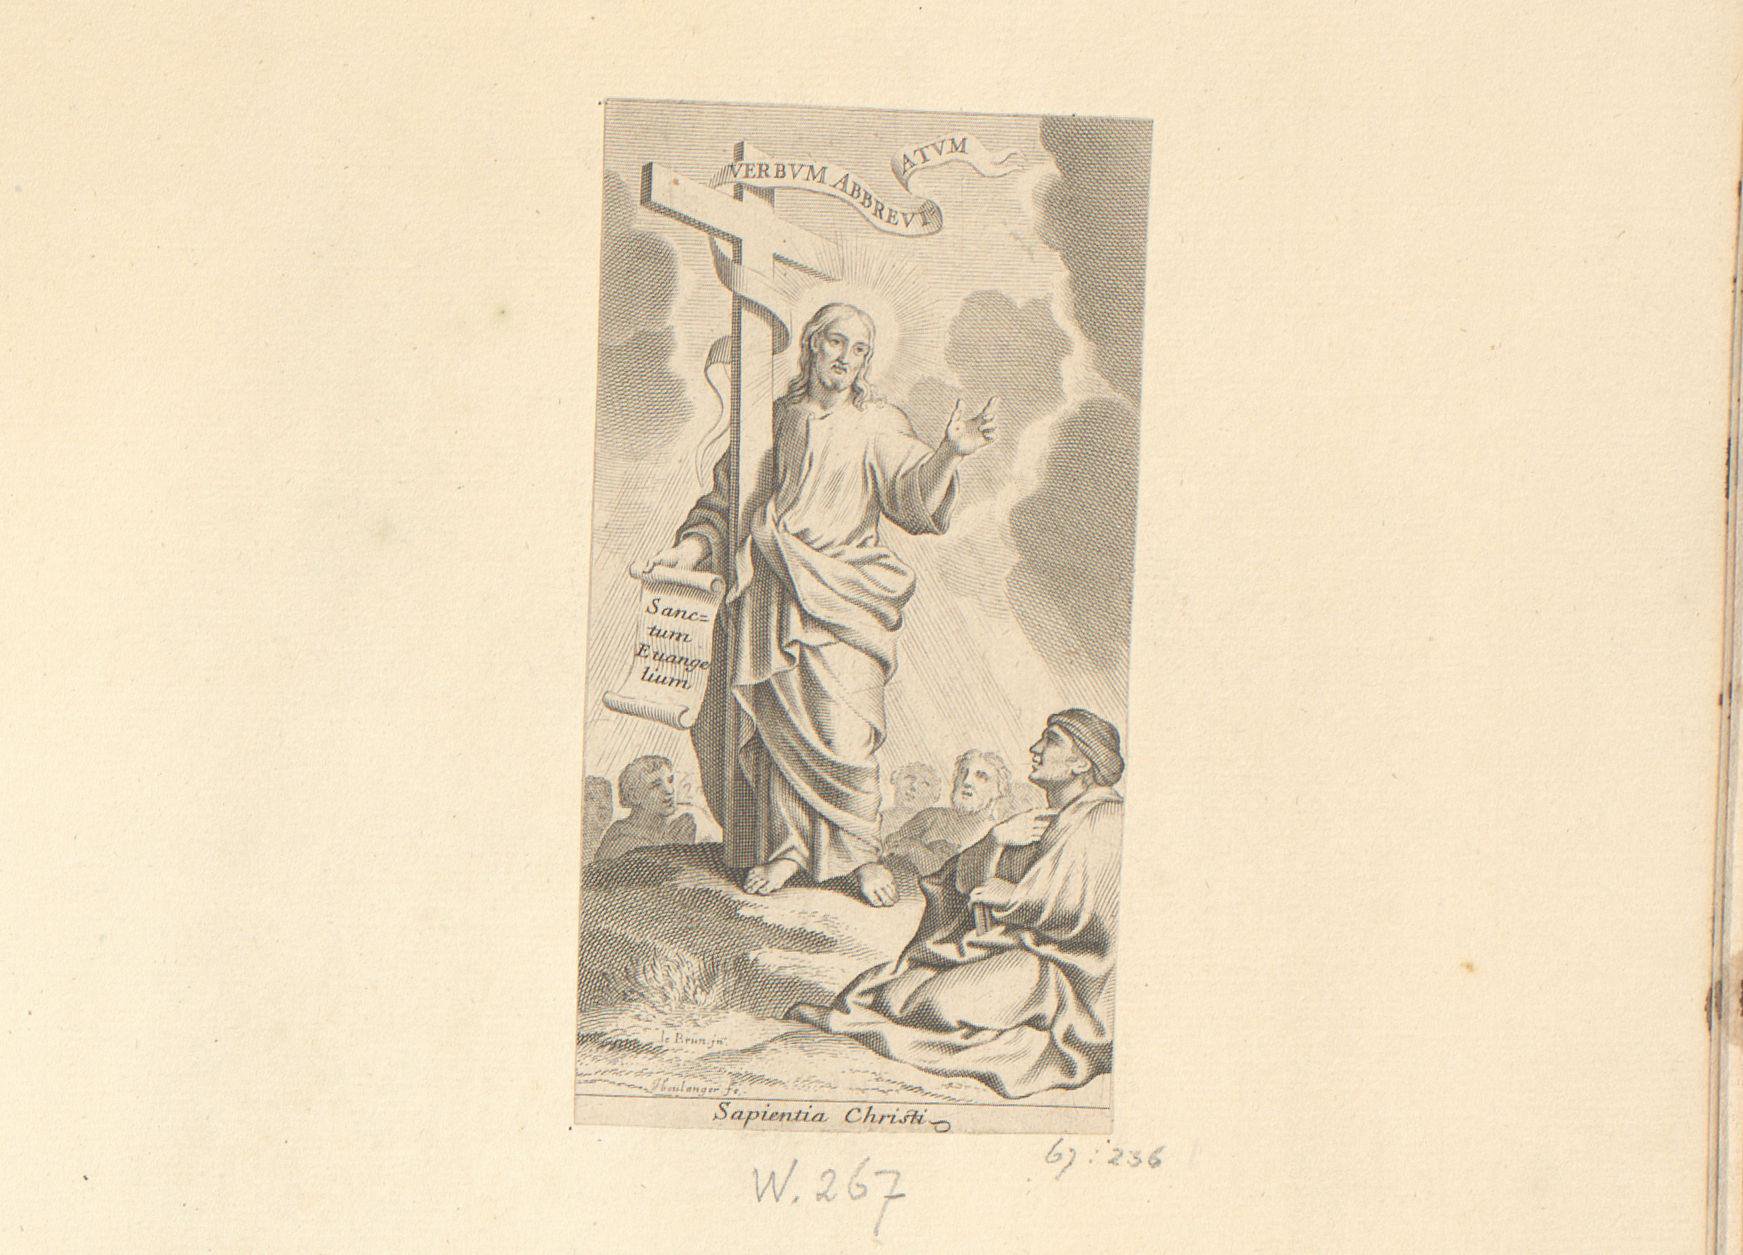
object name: album leaf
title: Predikende Christus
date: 1616-1680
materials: paper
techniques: engraving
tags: christ preaching in the open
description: Deze prent is gebruikt als boekillustratie tegenover de titelpagina in een onbekende publicatie.